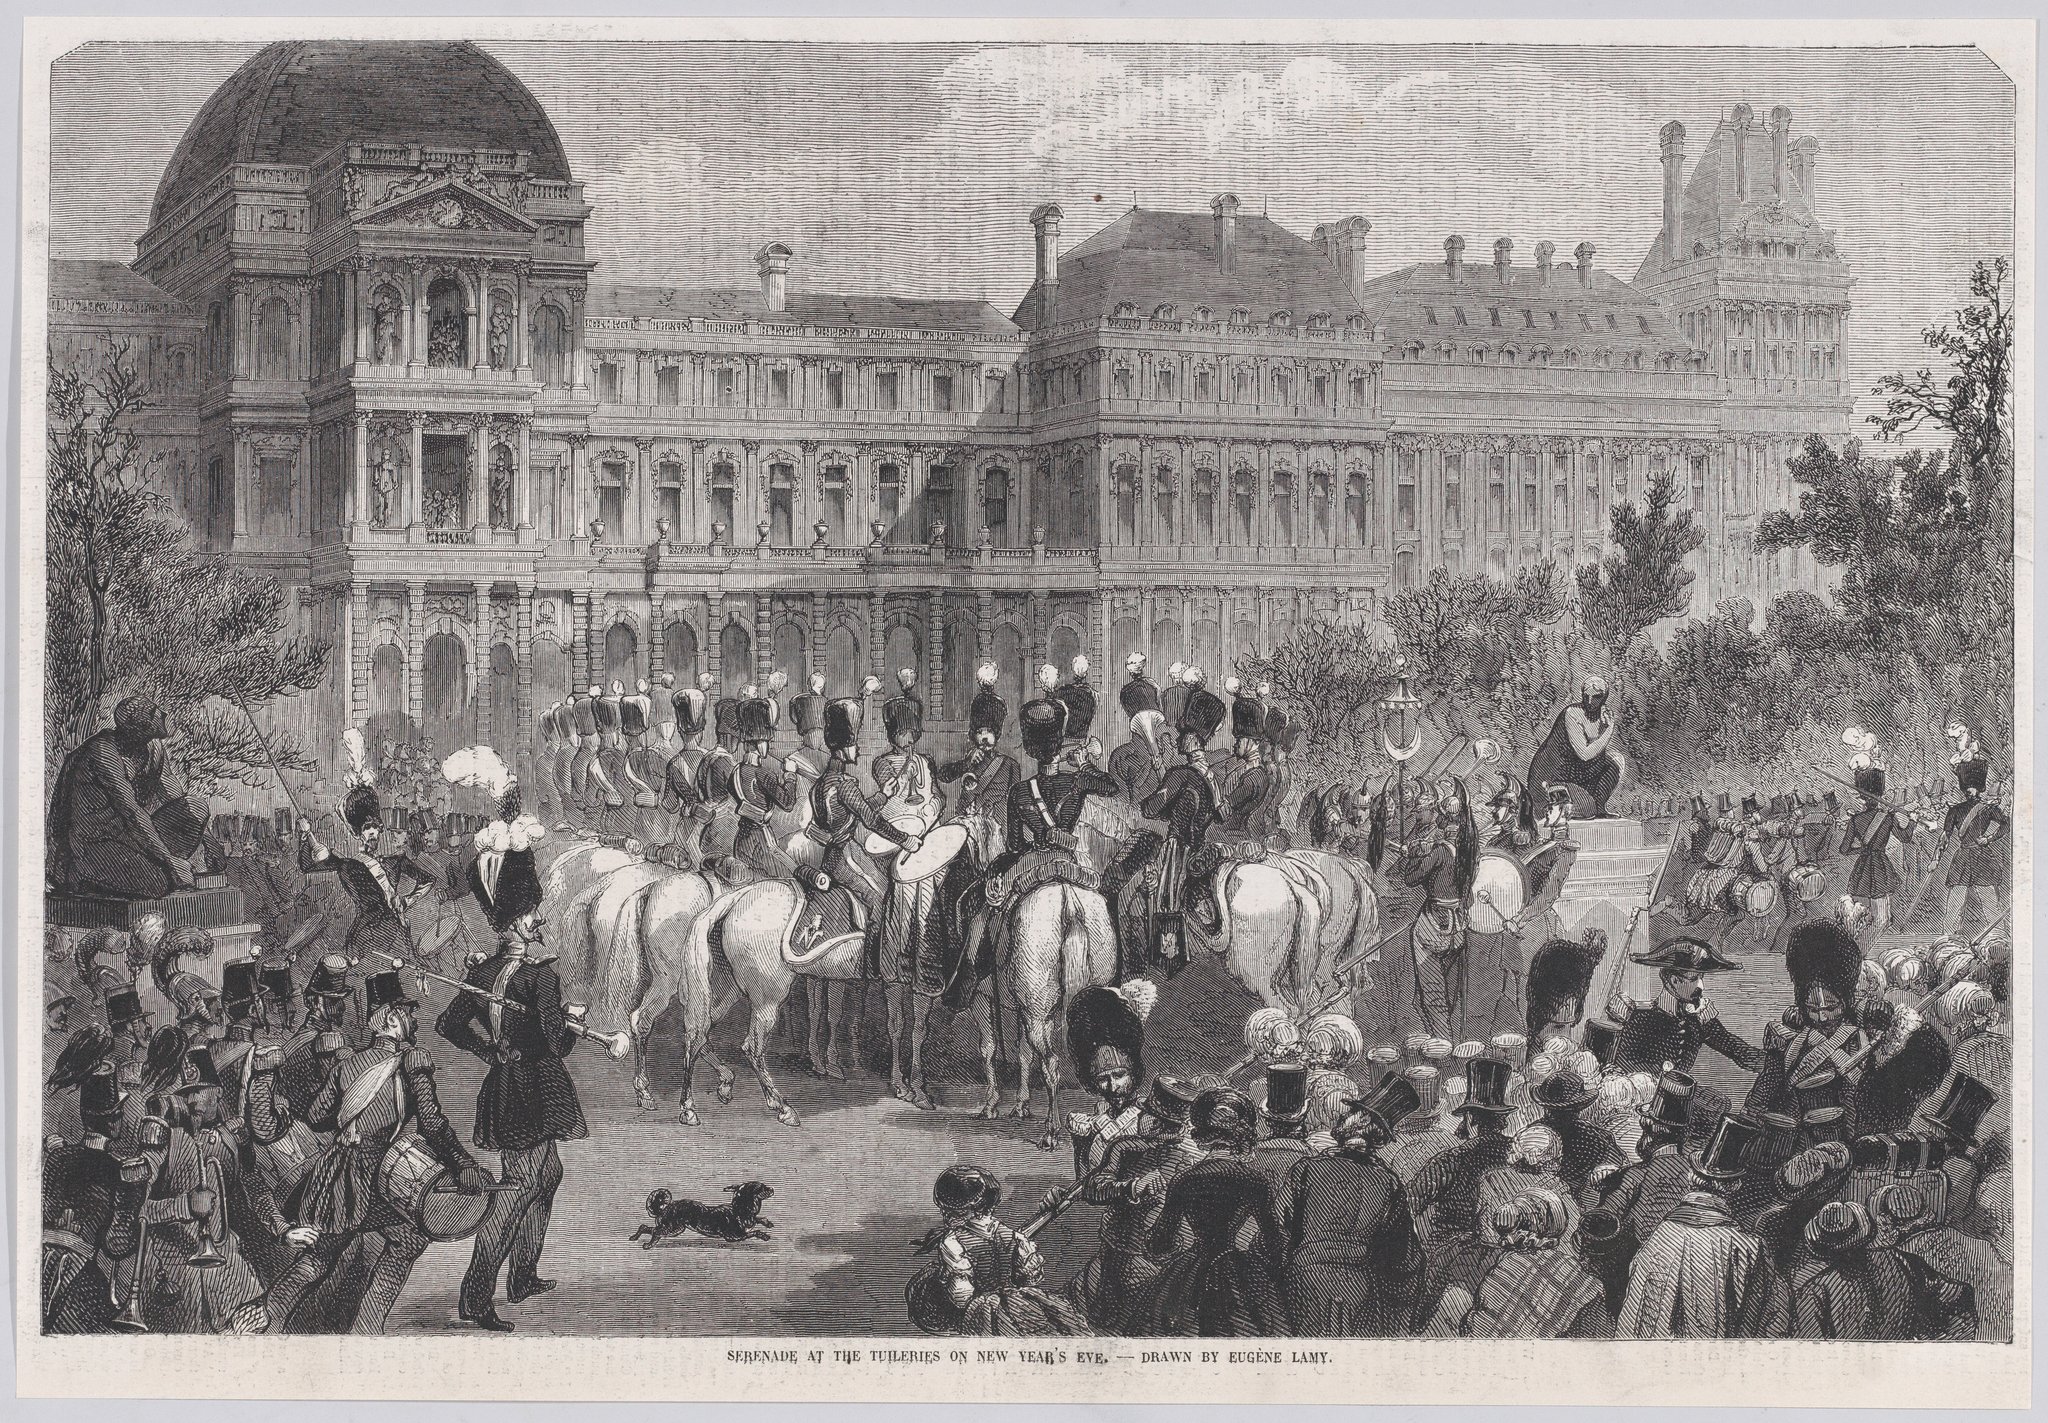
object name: print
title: Serenade at the Tuileries on New Year's Eve, from "Illustrated London News"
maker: eugène-louis lami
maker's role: artist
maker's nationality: french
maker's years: 1800-1890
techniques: engraving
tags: soldiers,men,horses,crowd